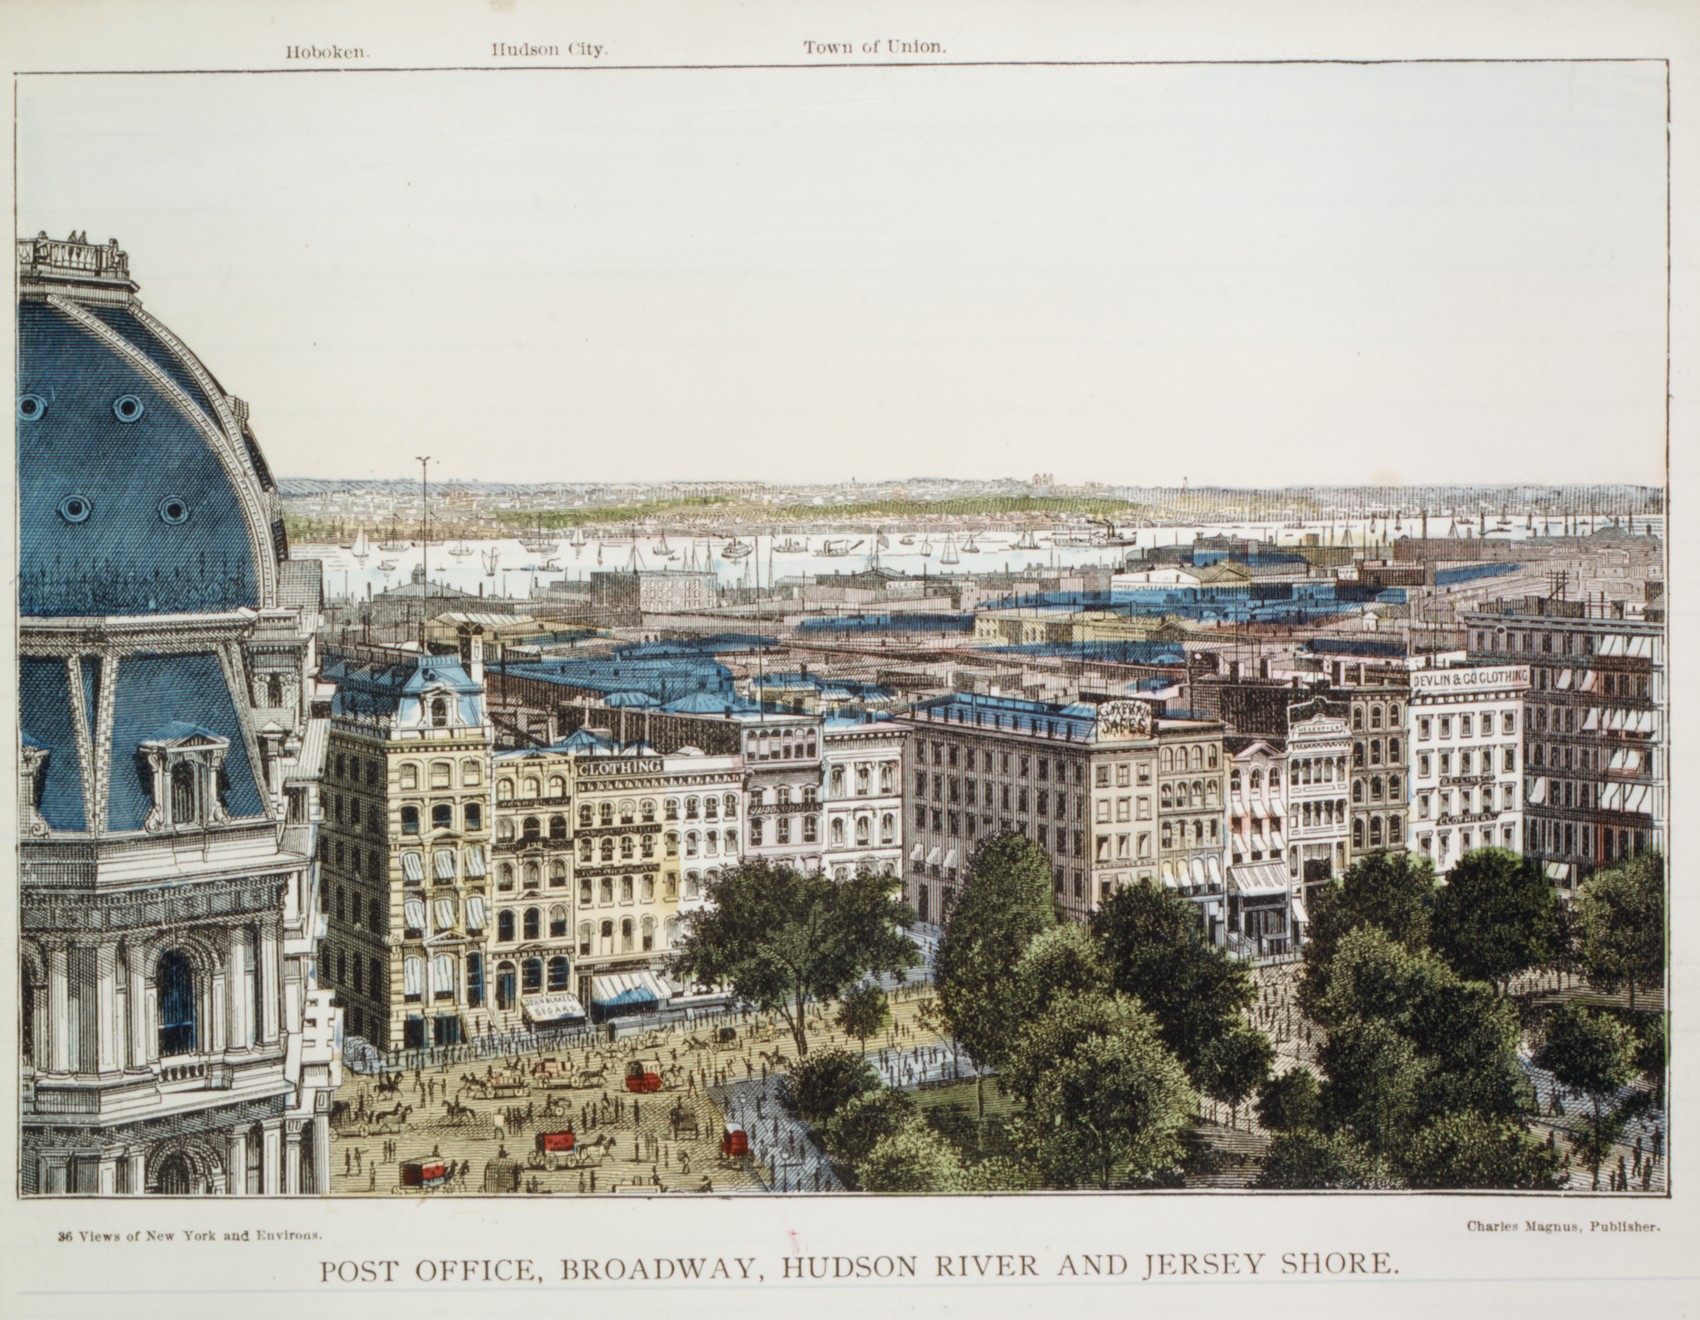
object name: print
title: Post Office, Broadway, Hudson River and Jersey Shore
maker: charles magnus & company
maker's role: publisher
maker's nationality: american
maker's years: 1854-1880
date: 1878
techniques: hand coloring, engraving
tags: buildings,cities,new york city